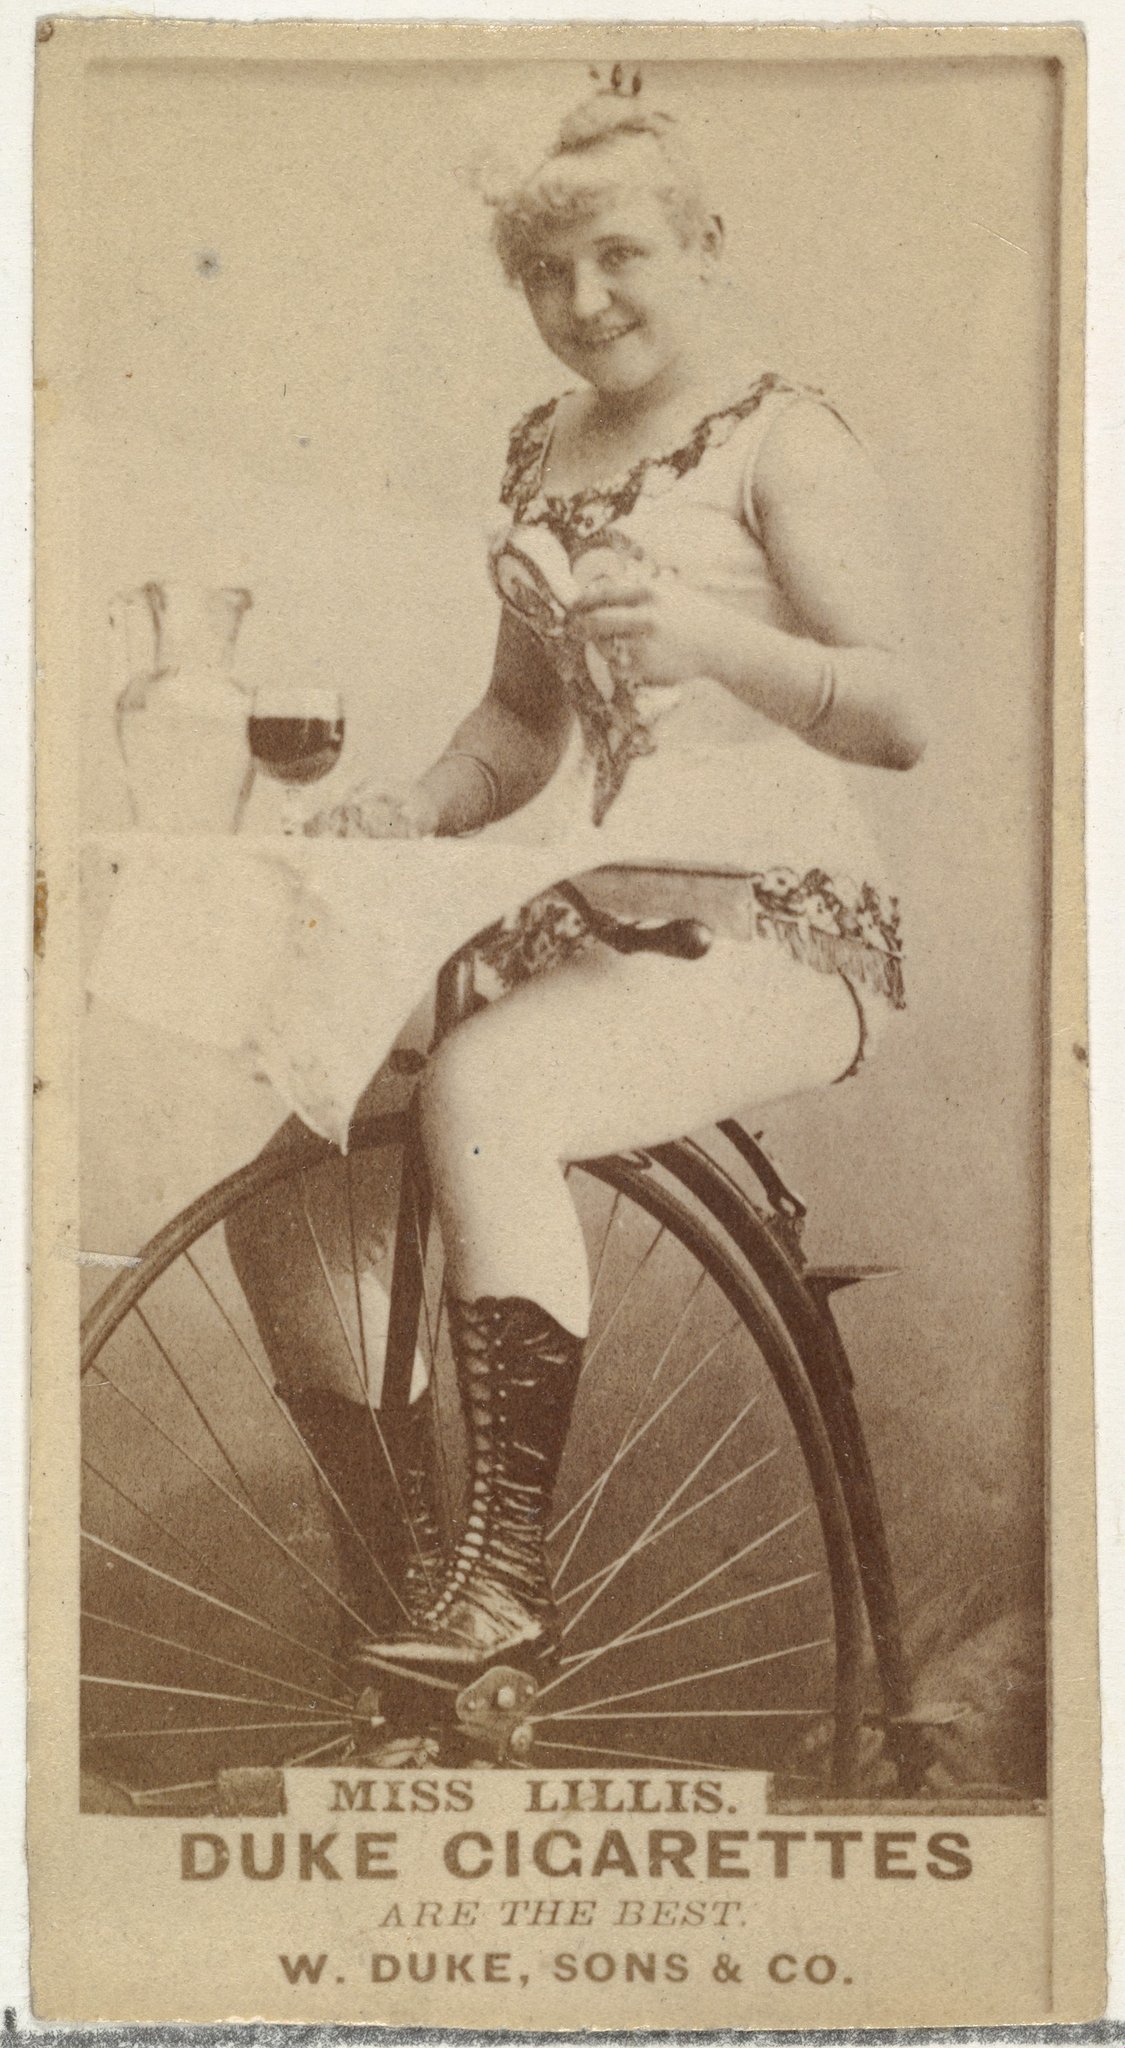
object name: photograph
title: Miss Lillis, from the Actors and Actresses series (N145-7) issued by Duke Sons & Co. to promote Duke Cigarettes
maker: w. duke, sons & co.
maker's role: publisher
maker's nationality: american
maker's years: 1870-1920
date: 1880-1889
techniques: albumen silver print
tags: portraits,women,actresses